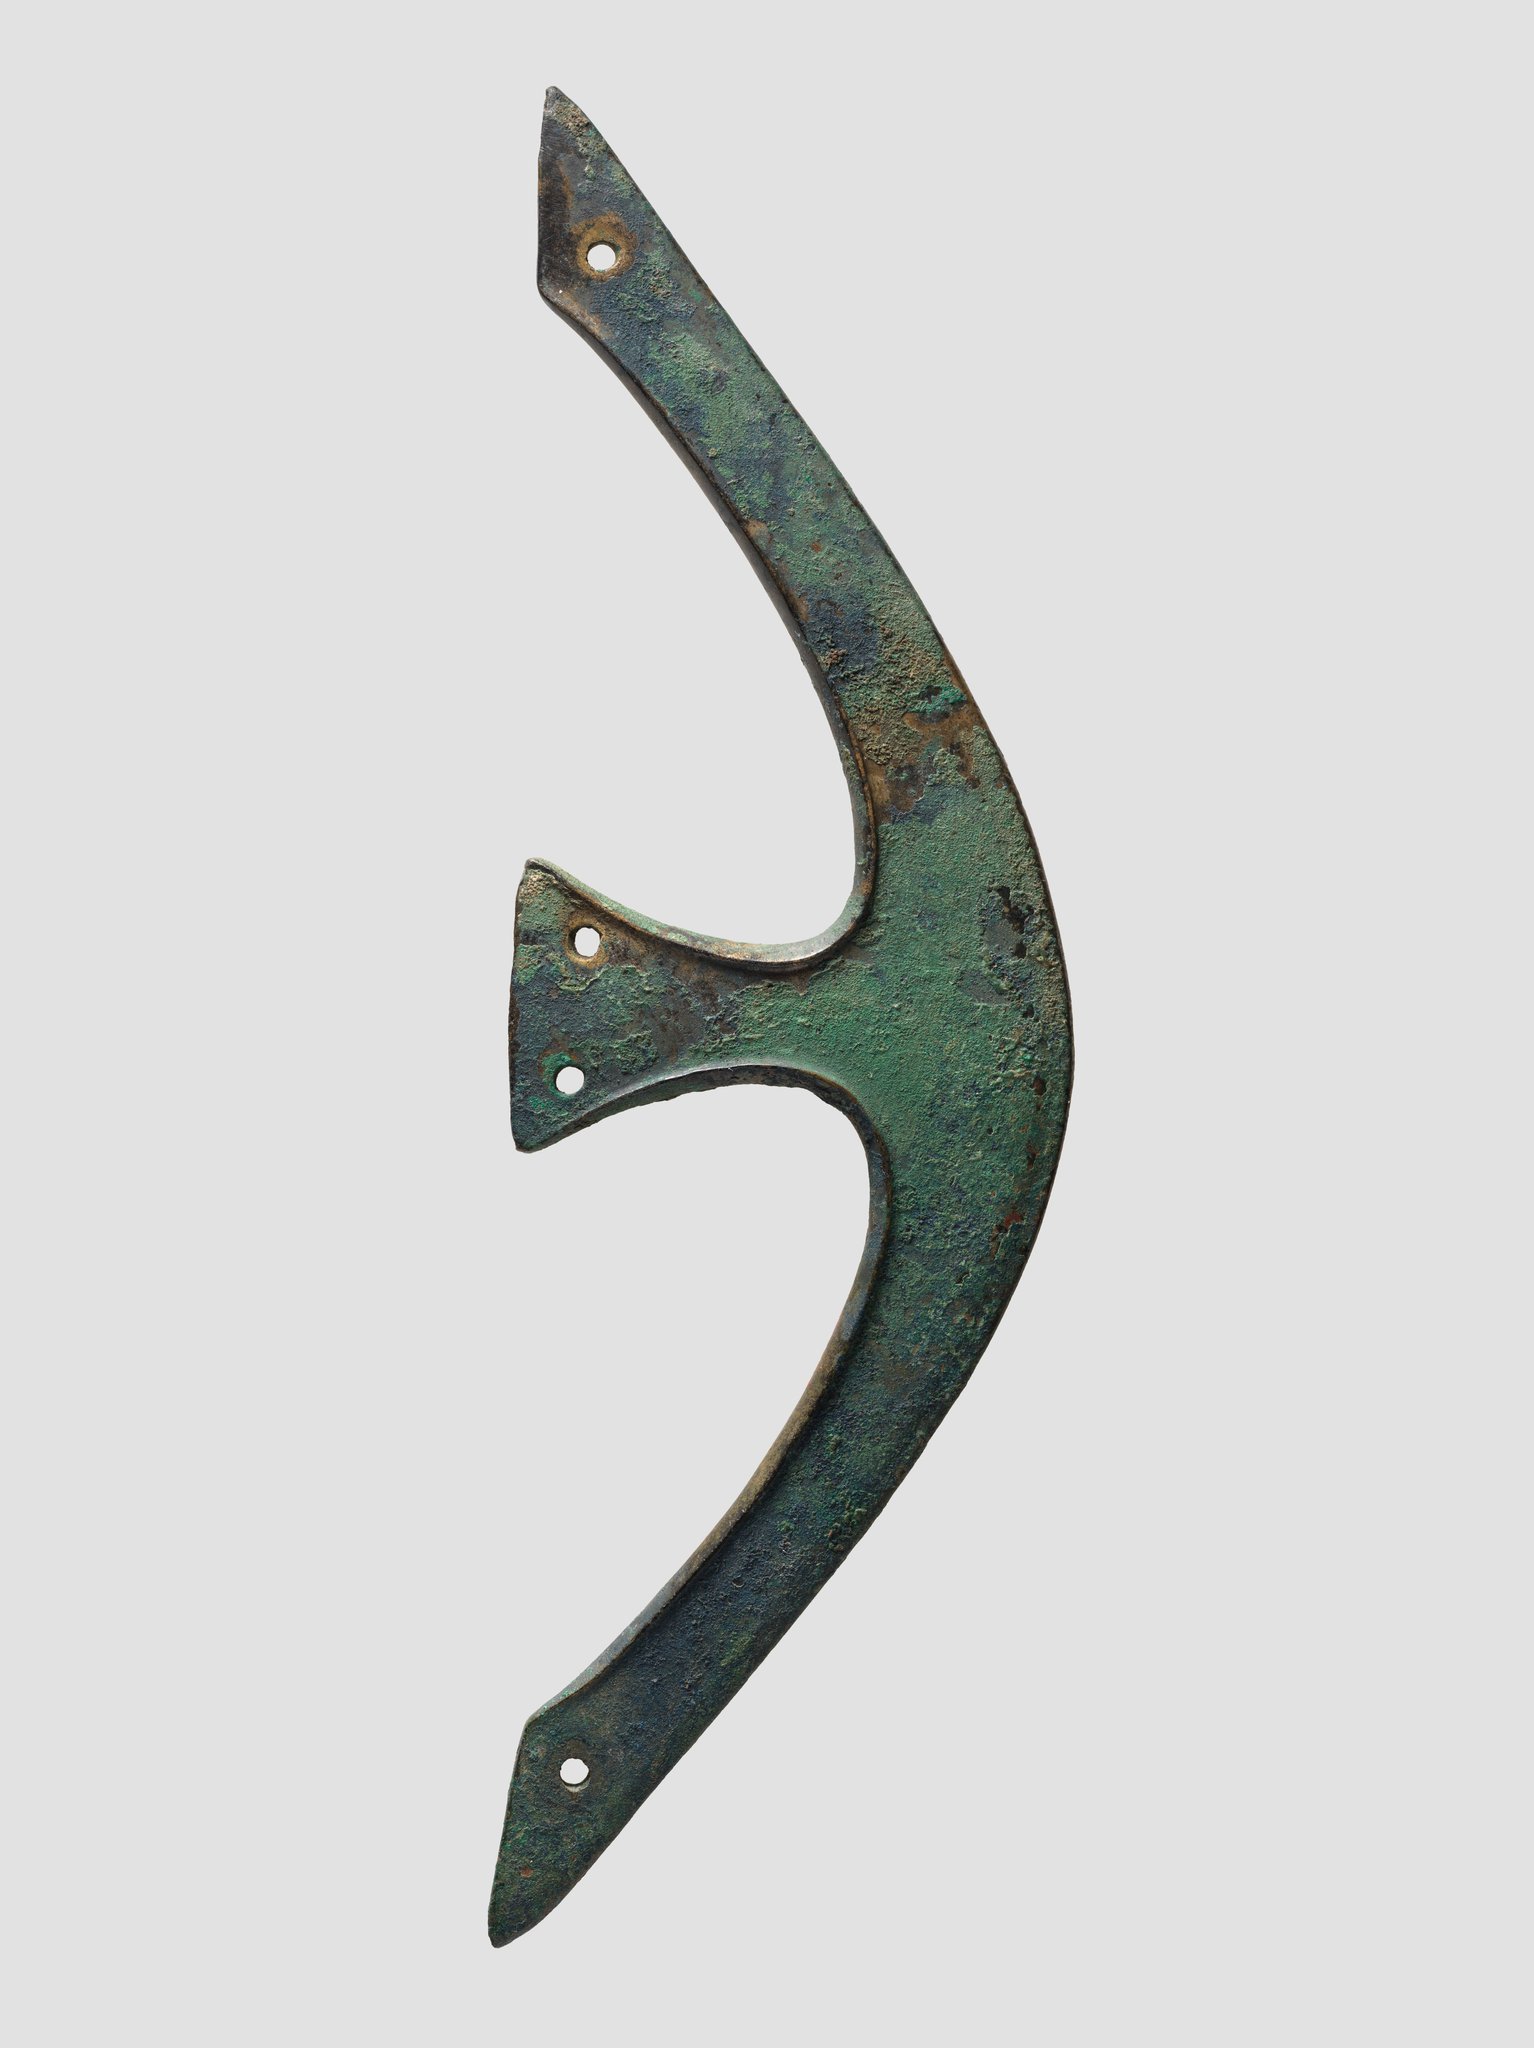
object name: axe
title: Crescent-shaped axe head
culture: hattian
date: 2300-2000 BCE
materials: bronze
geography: central anatolia